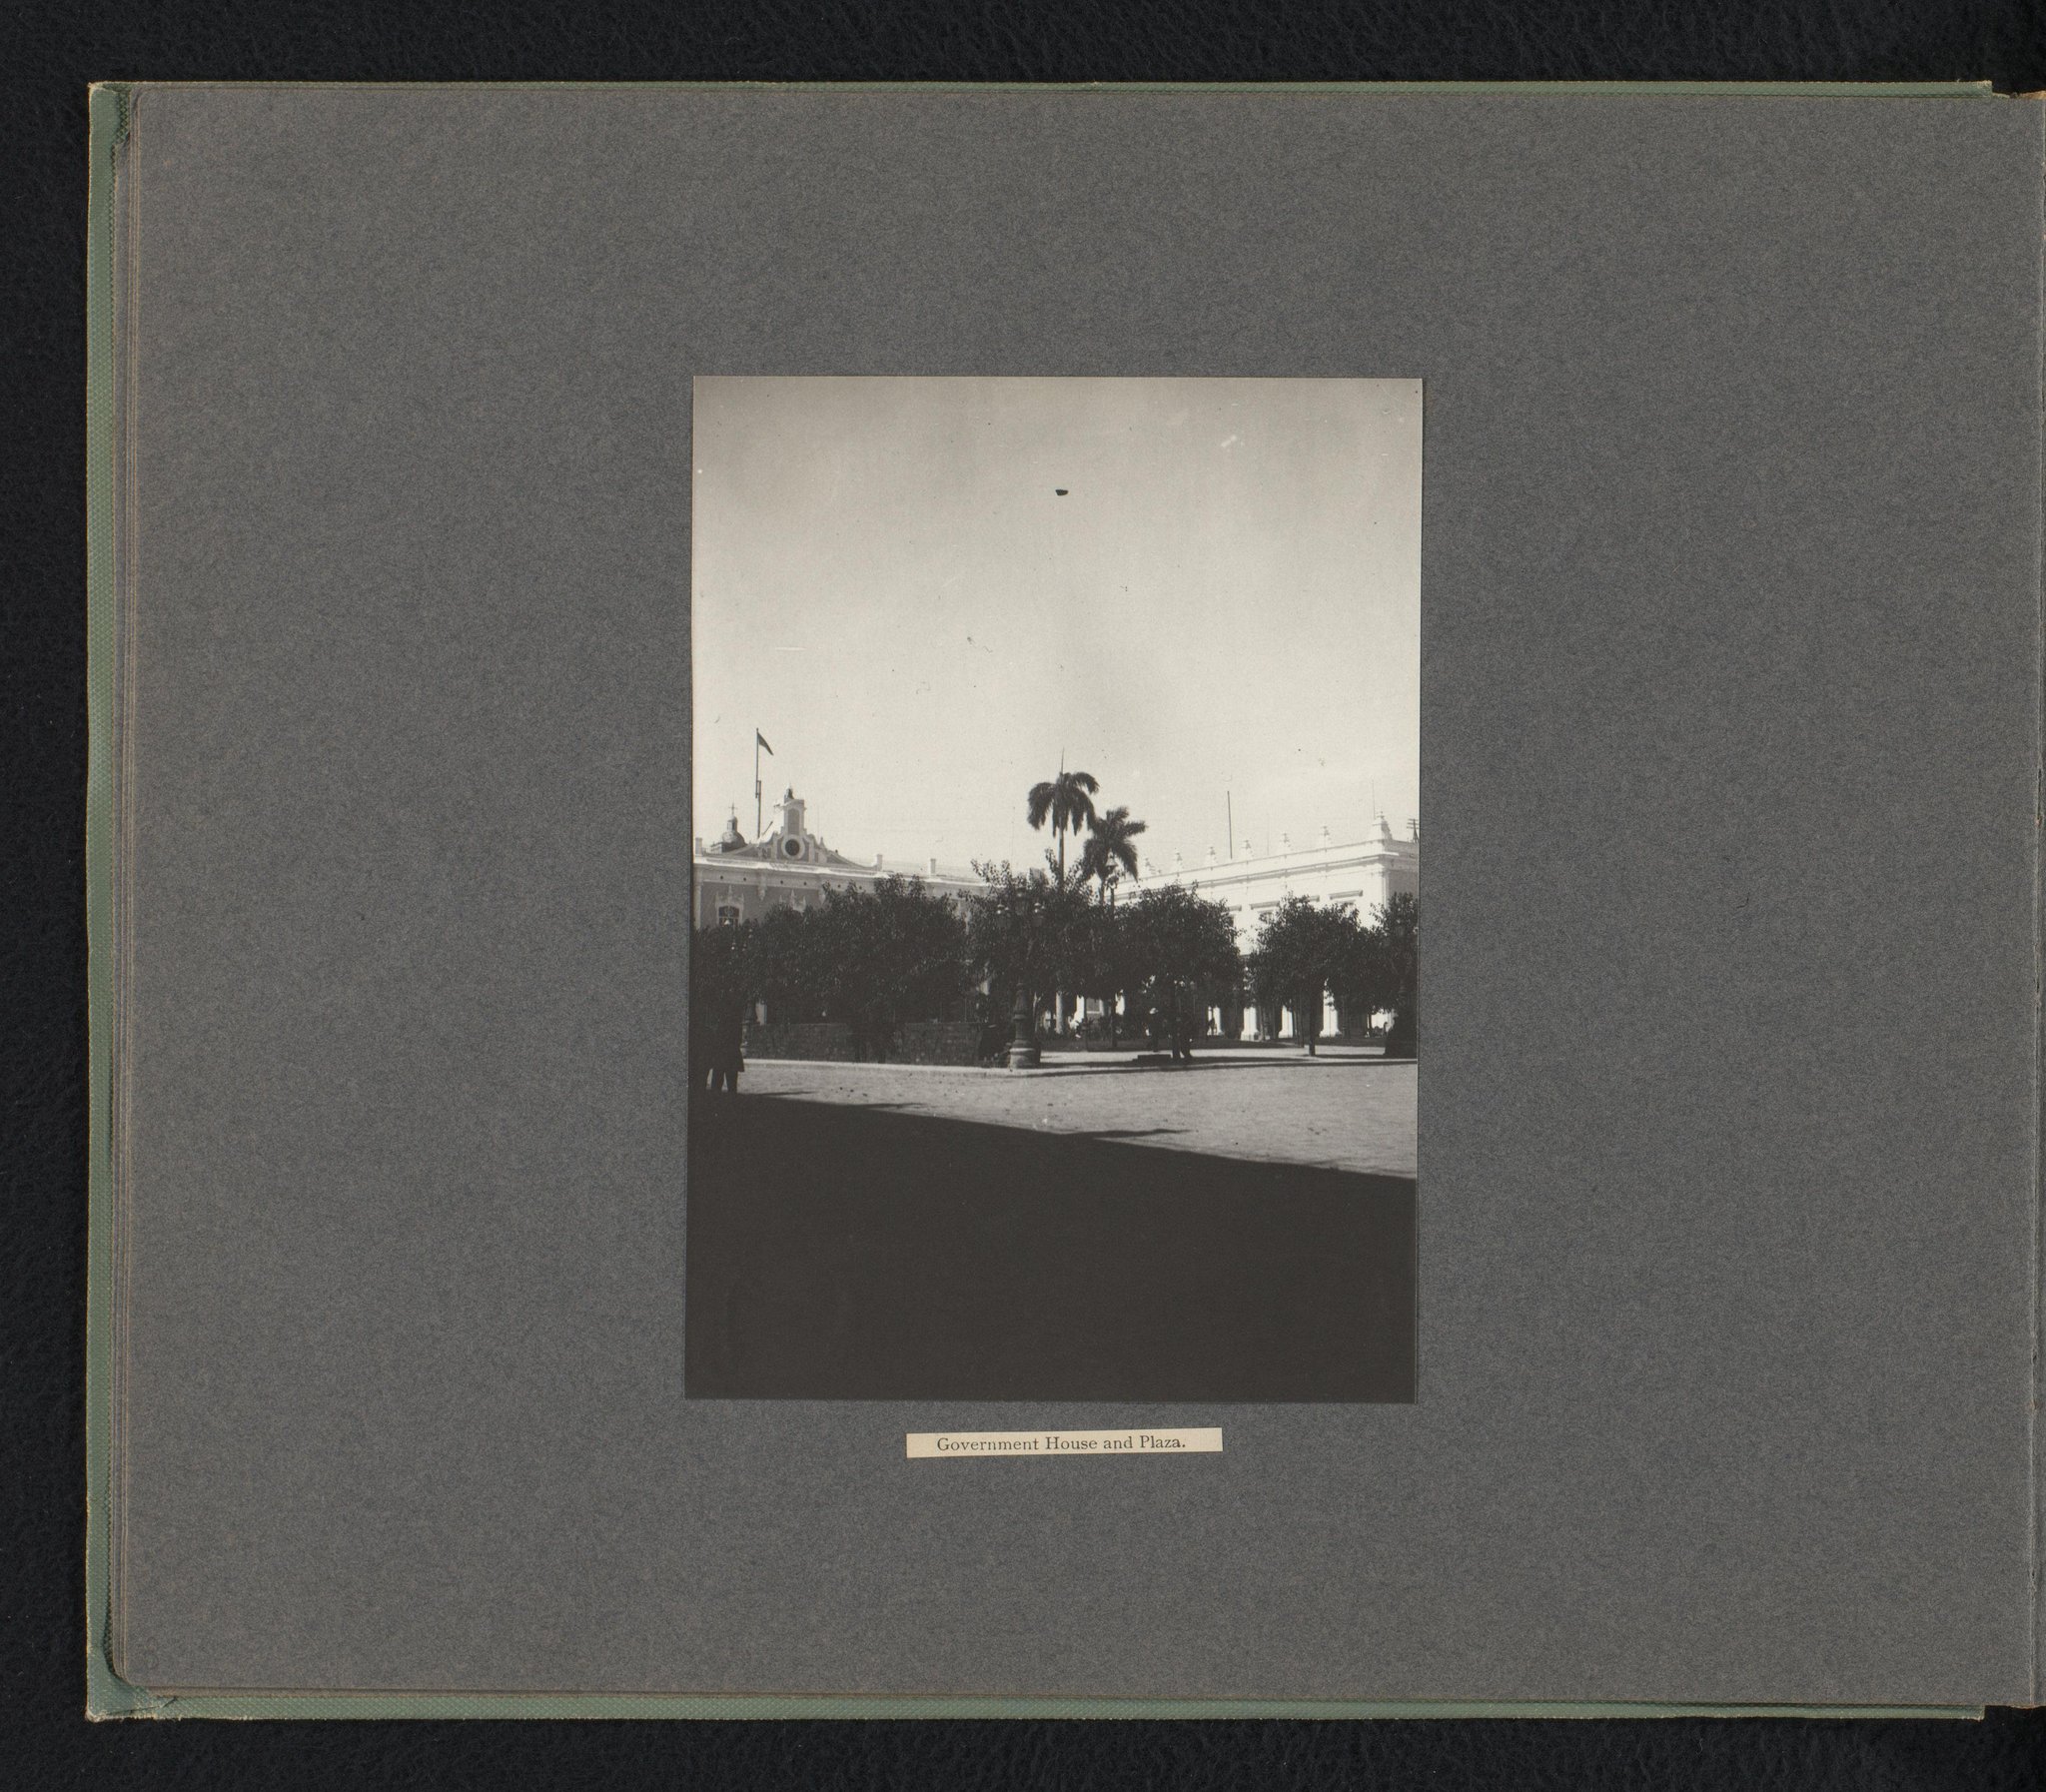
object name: album leaf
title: Government House and Plaza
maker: Anonymous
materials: paper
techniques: platinum process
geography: havana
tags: harbour, gulf, bay, landscape with tower or castle